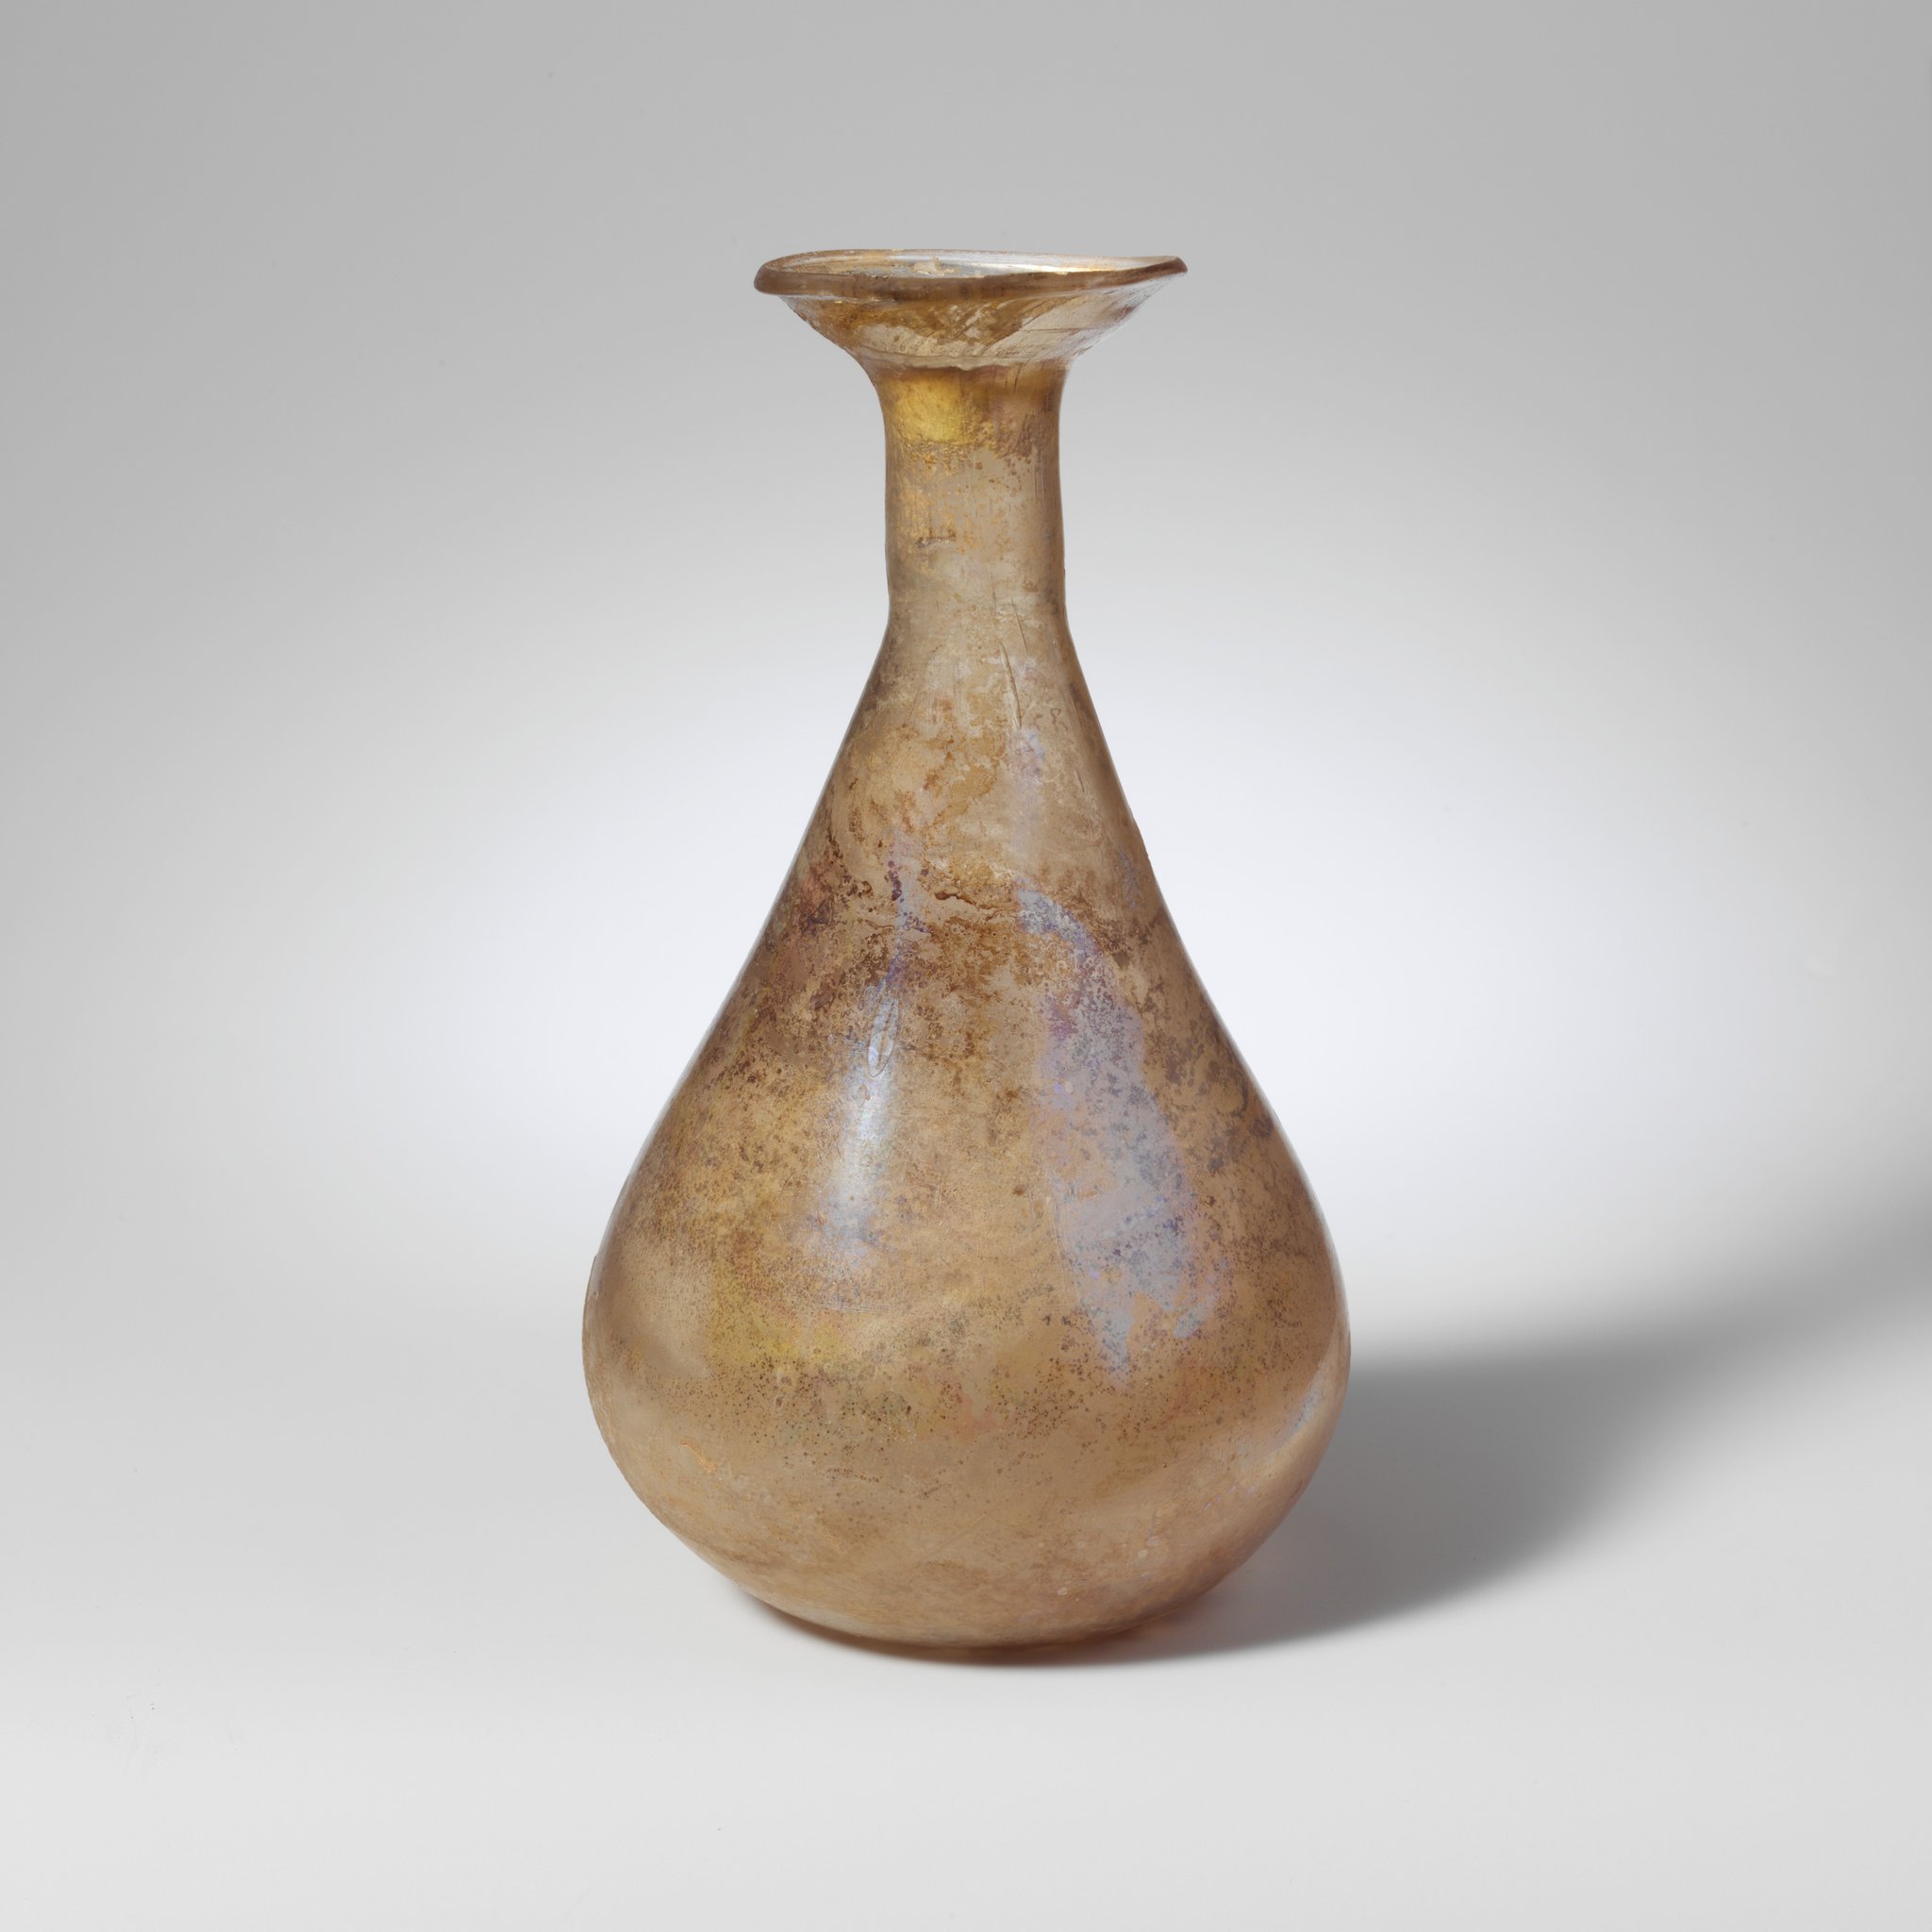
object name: flask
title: Glass flask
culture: roman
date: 101-300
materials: glass